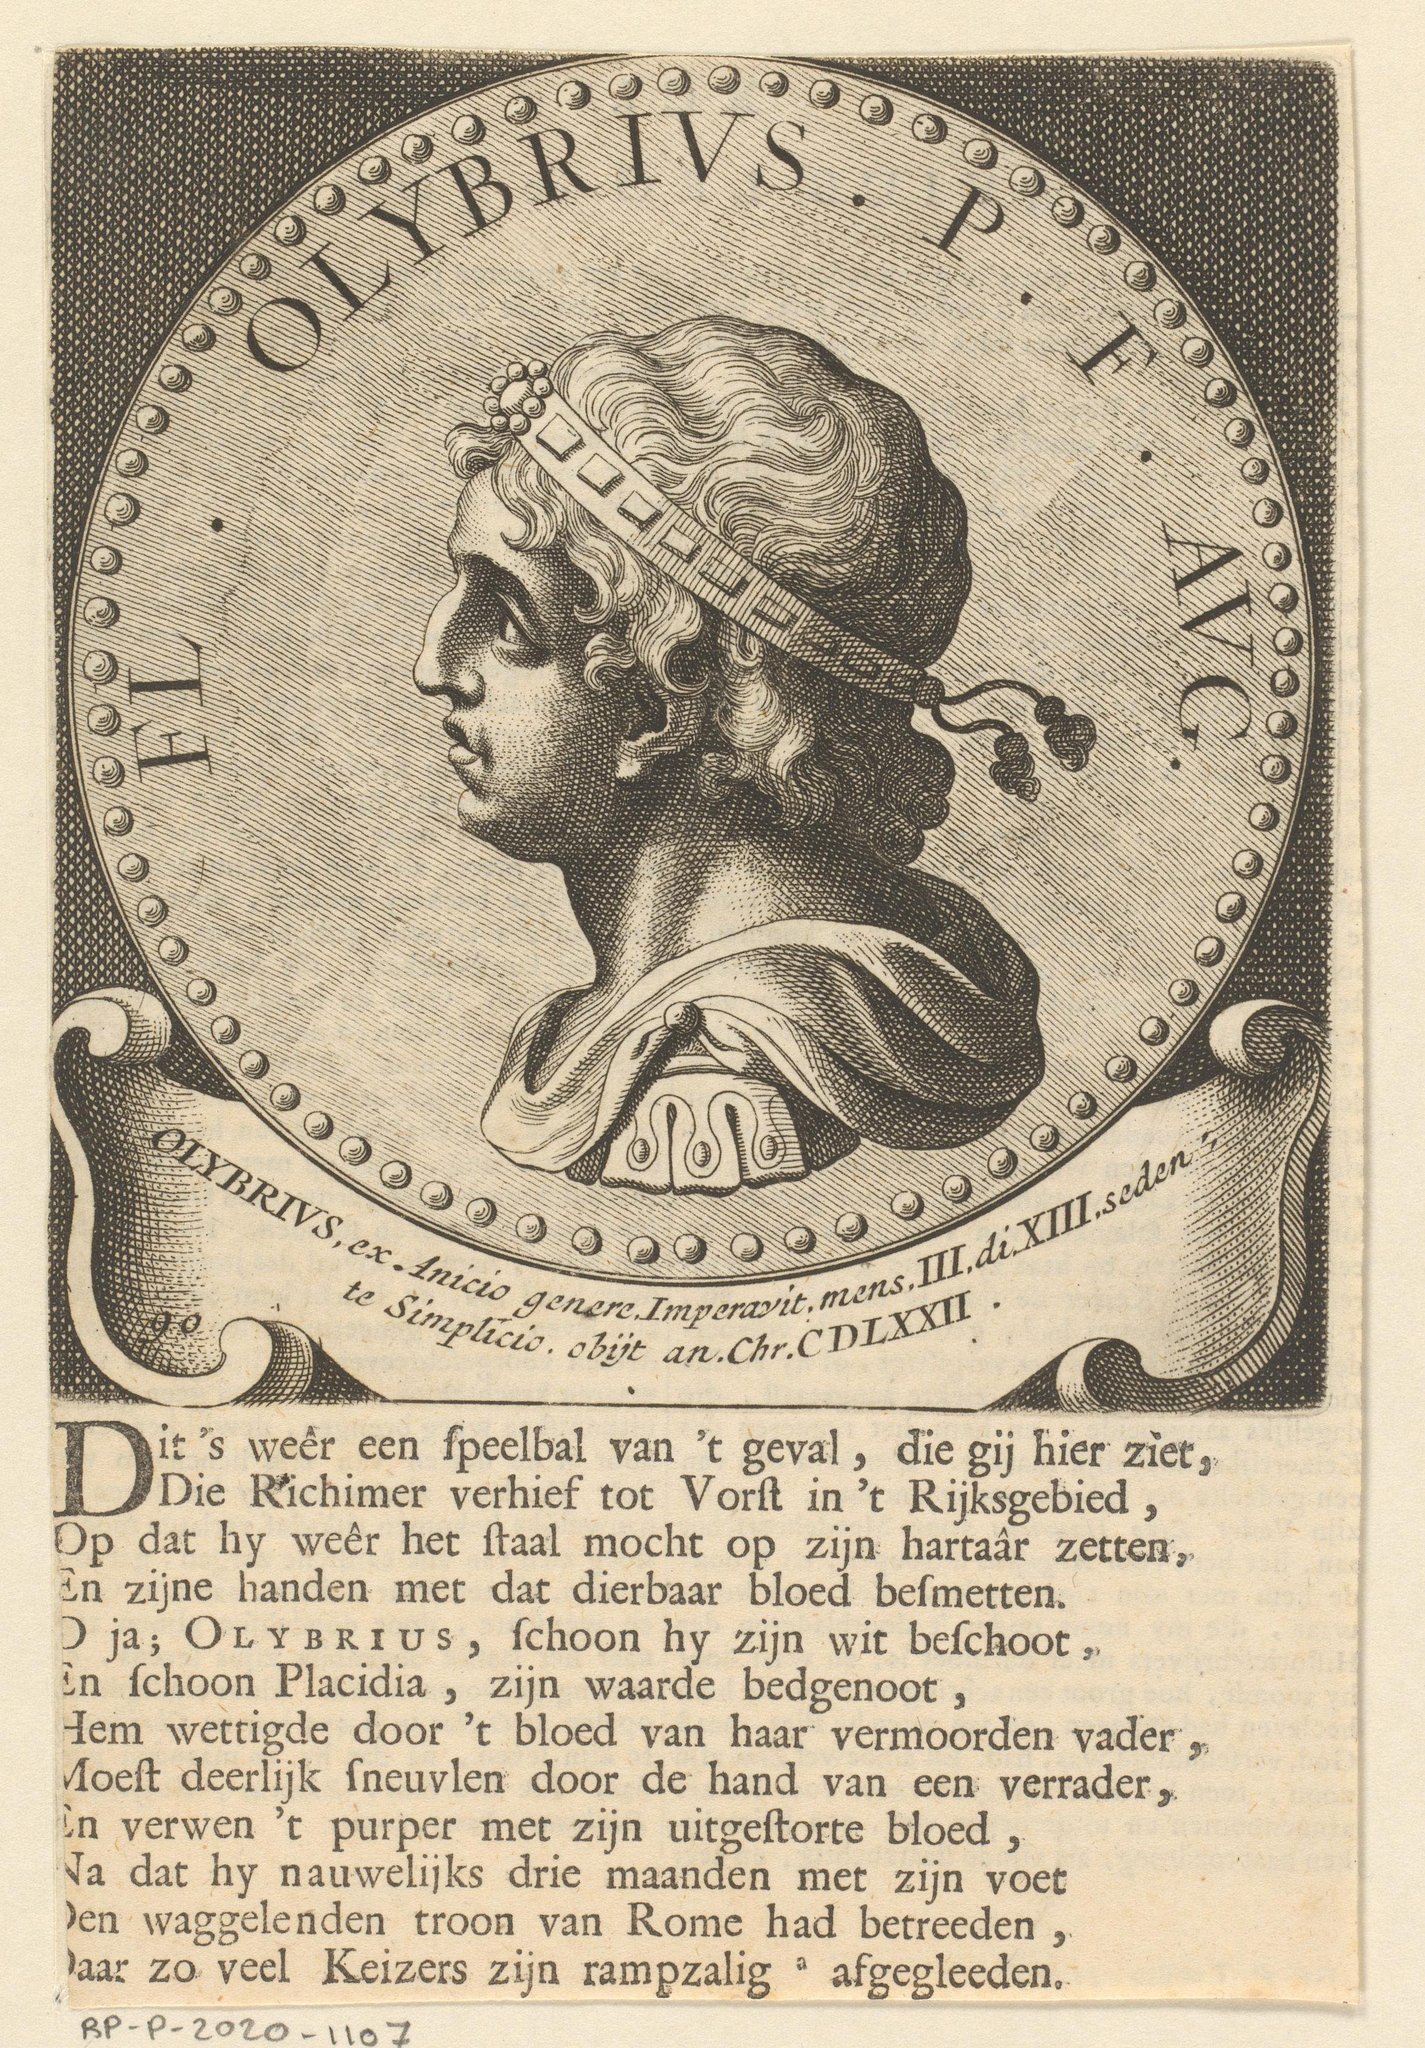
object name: book illustration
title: Portret van keizer Olybrius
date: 1697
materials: paper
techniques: engraving, etching, letterpress printing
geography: utrecht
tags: historical persons, emperor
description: Prent uit: Bogaert, Abraham. De Roomsche monarchy, vertoont in de muntbeelden der westersche en oostersche keizeren (...). Utrecht: François Halma en Willem van de Water, 1697, p. 287. Eerste staat verschenen in een grotere prent met twaalf portretten, gedateerd 1695.